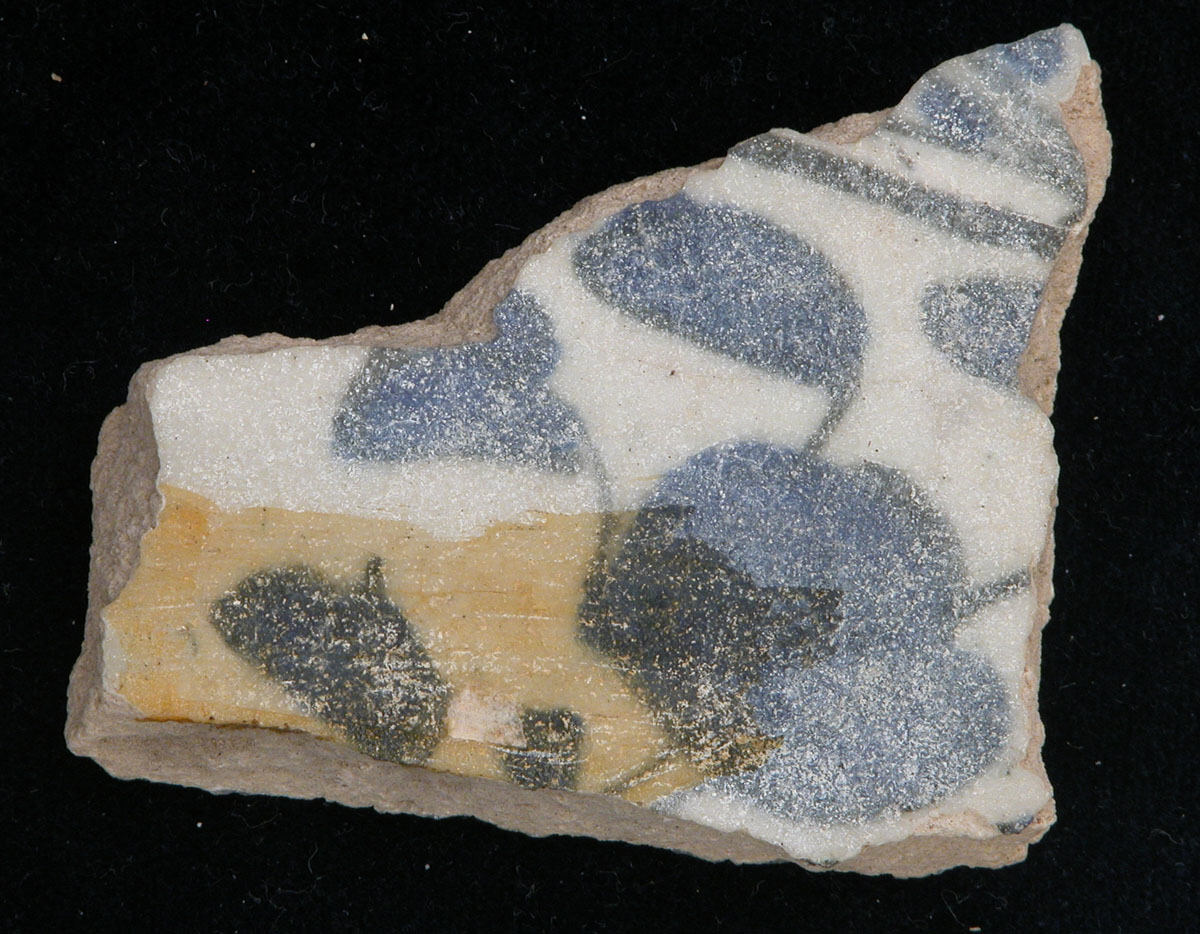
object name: fragment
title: Ceramic Fragment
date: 1201-1600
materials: stonepaste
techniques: glazing, painting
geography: saudi arabia